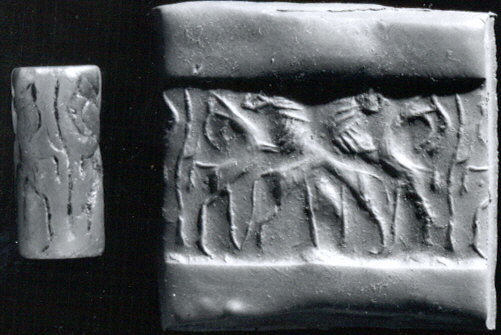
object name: cylinder seal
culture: sumerian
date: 2600-2350 BCE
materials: stone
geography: mesopotamia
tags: animals